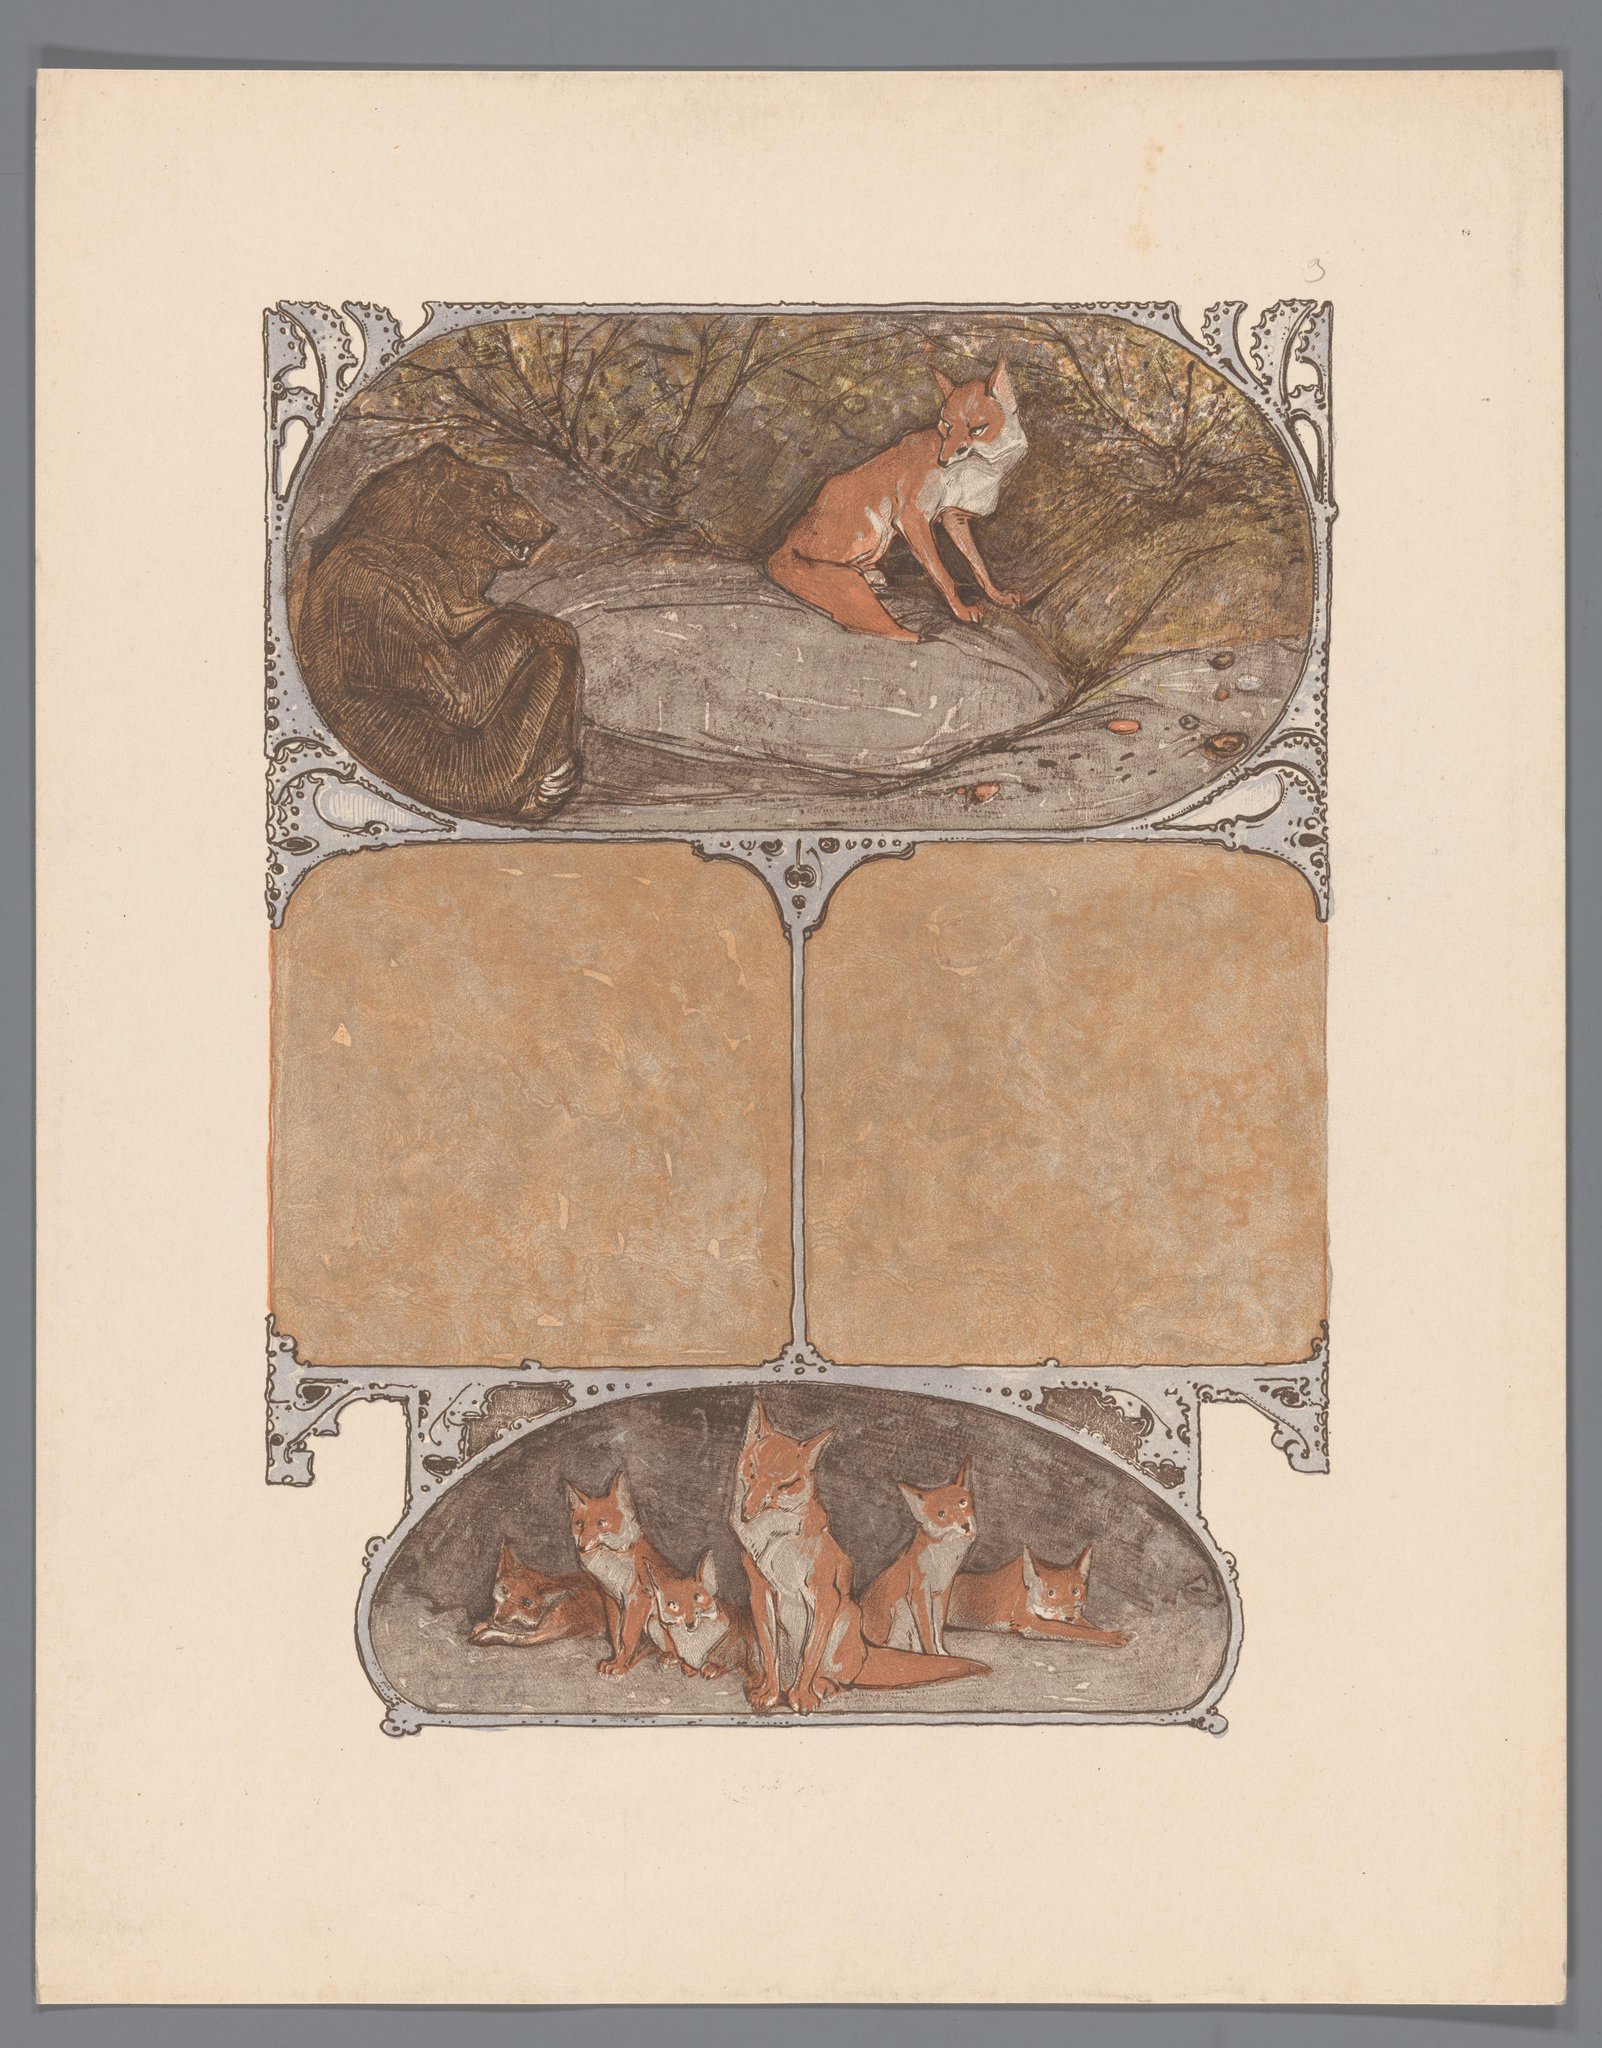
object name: boekillustratie ontwerp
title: Beer (Bruun) en vos (Reinaert)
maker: bernard willem wierink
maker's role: draughtsman, print maker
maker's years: 1856-1939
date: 1910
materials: paper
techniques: lithograph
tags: fable of reynard the fox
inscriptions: collector's mark: Lugt 2228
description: Ontwerp voor: Streuvels, Stijn (Frank Lateur). Reinaert de Vos naar verschillende uitgaven van het middeleeuwsche epos. Amsterdam: L.J. Veen, 1910.